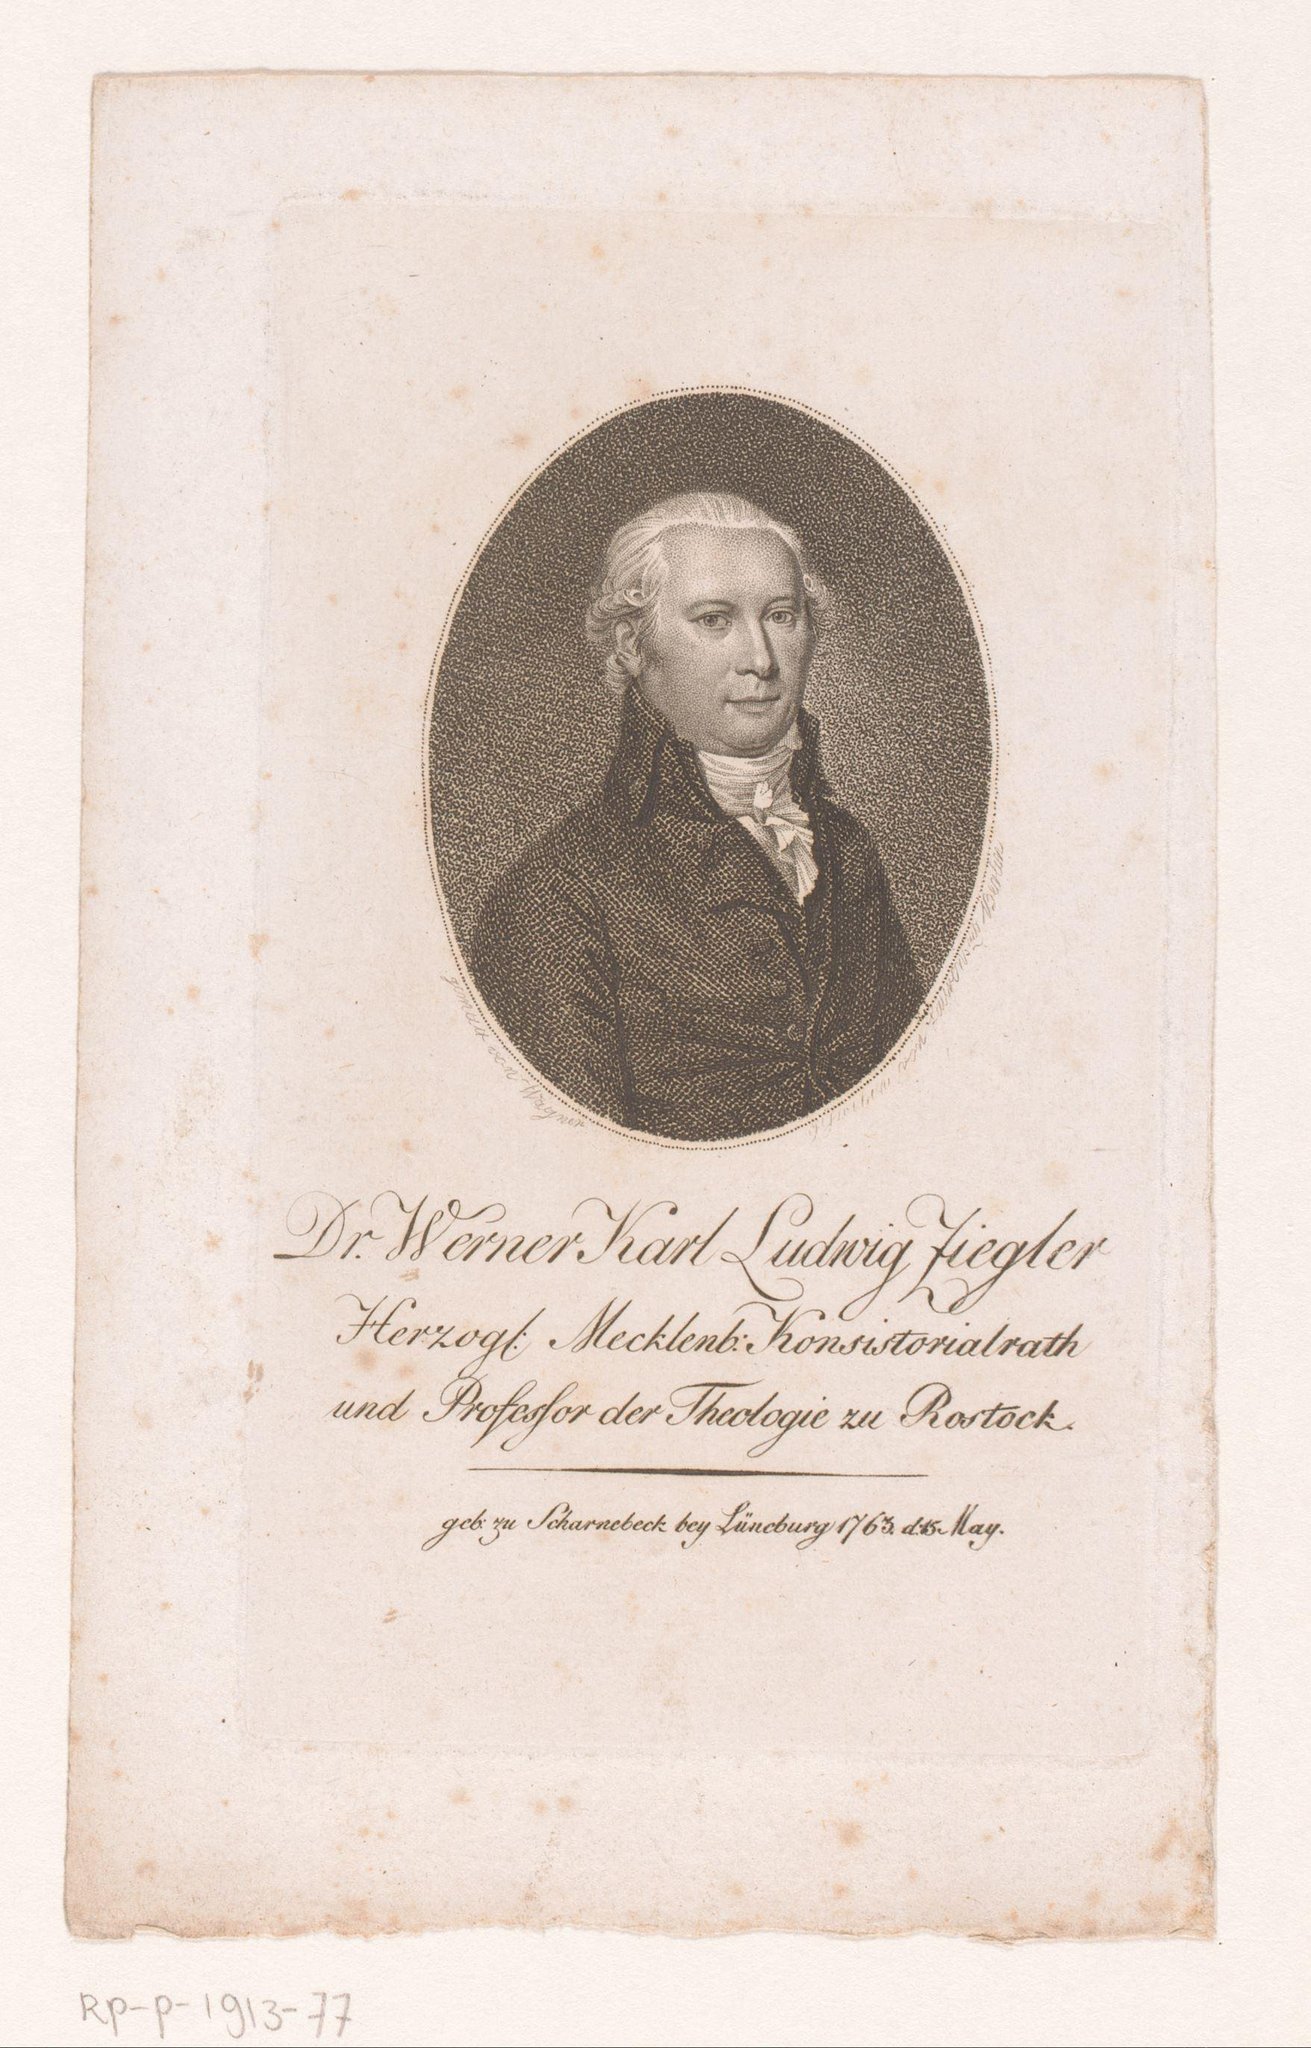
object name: print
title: Portret van Werner Karl Ludwig Ziegler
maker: johann daniel laurenz (ii)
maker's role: draughtsman, print maker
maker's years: 1770-1832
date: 1780-1832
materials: paper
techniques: etching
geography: berlin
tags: theologian, historical persons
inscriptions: collector's mark: Lugt 2228